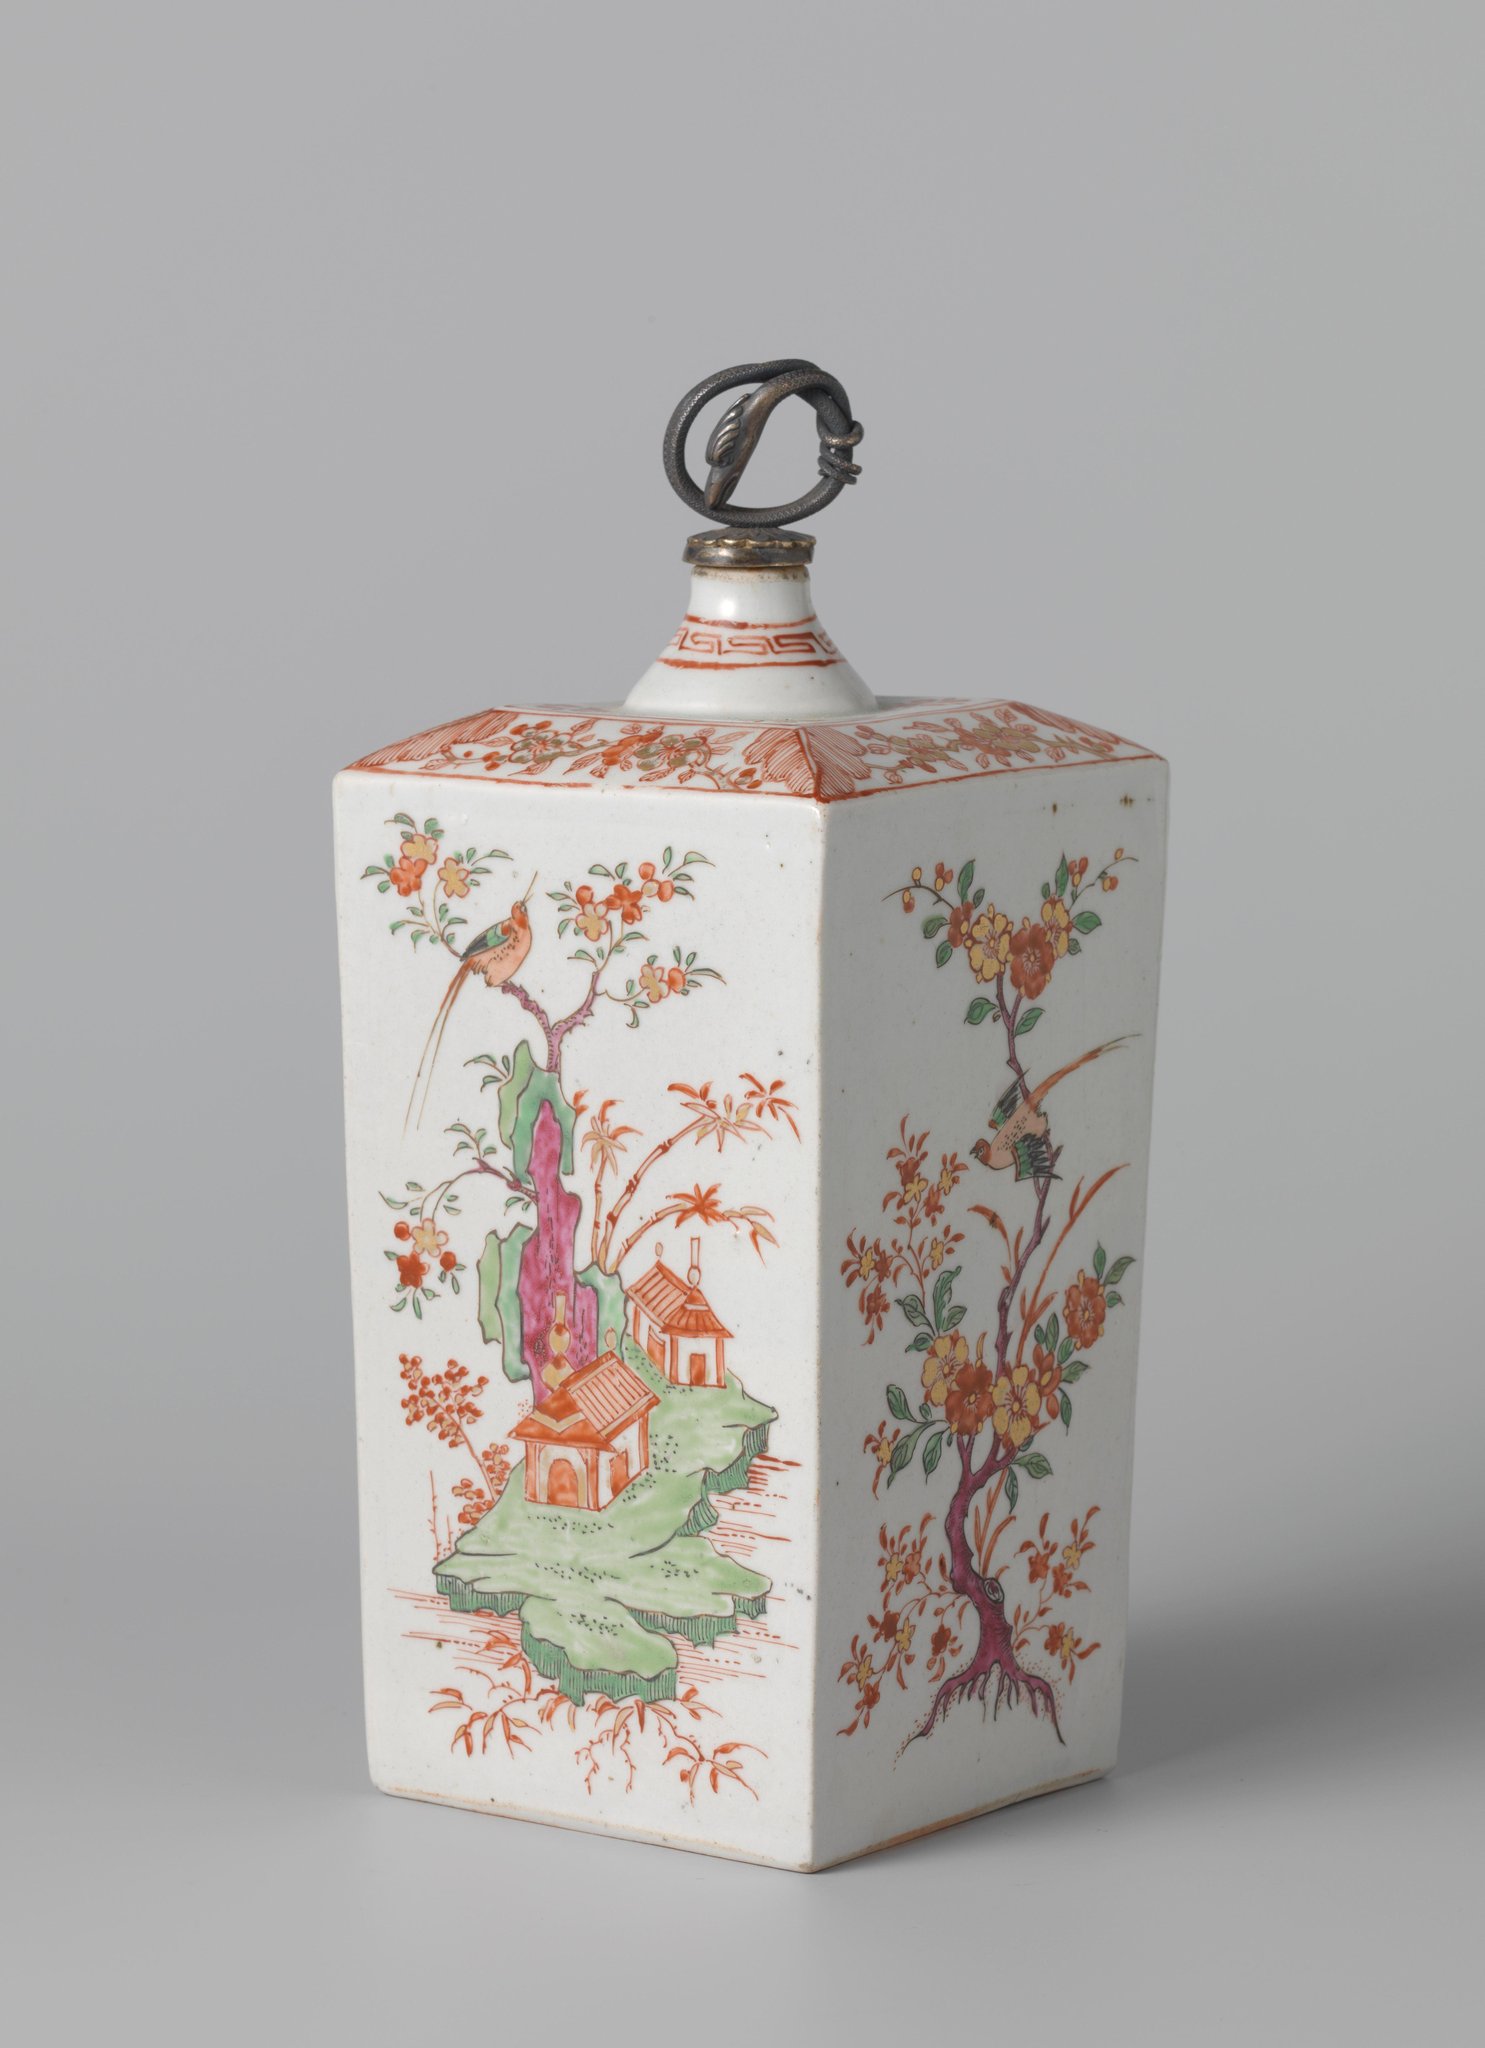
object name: bottle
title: Square bottle with birds, flowering plants and pavilions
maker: Anonymous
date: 1700-1724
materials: glaze, gold, paint, porcelain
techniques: firing, forming, gilding, vitrification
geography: arita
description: Vierkante fles van porselein met een verguld, beschilderd op het glazuur in rood, groen, geel, paars, zwart en goud. Op de wanden tweemaal paviljoens op een eiland met rotsen en bloeiende planten (bamboe), een vogel op een tak, en tweemaal een vliegende vogel bij een prunustak en bamboe. Op de schouder een band met prunustakken en een bladmotief; rond de hals ranken. Op de hals een meanderpatroon. De rand is afgeslepen. Arita, in Europa gedecoreerd[?] in de Japanse Kakiemon-stijl.